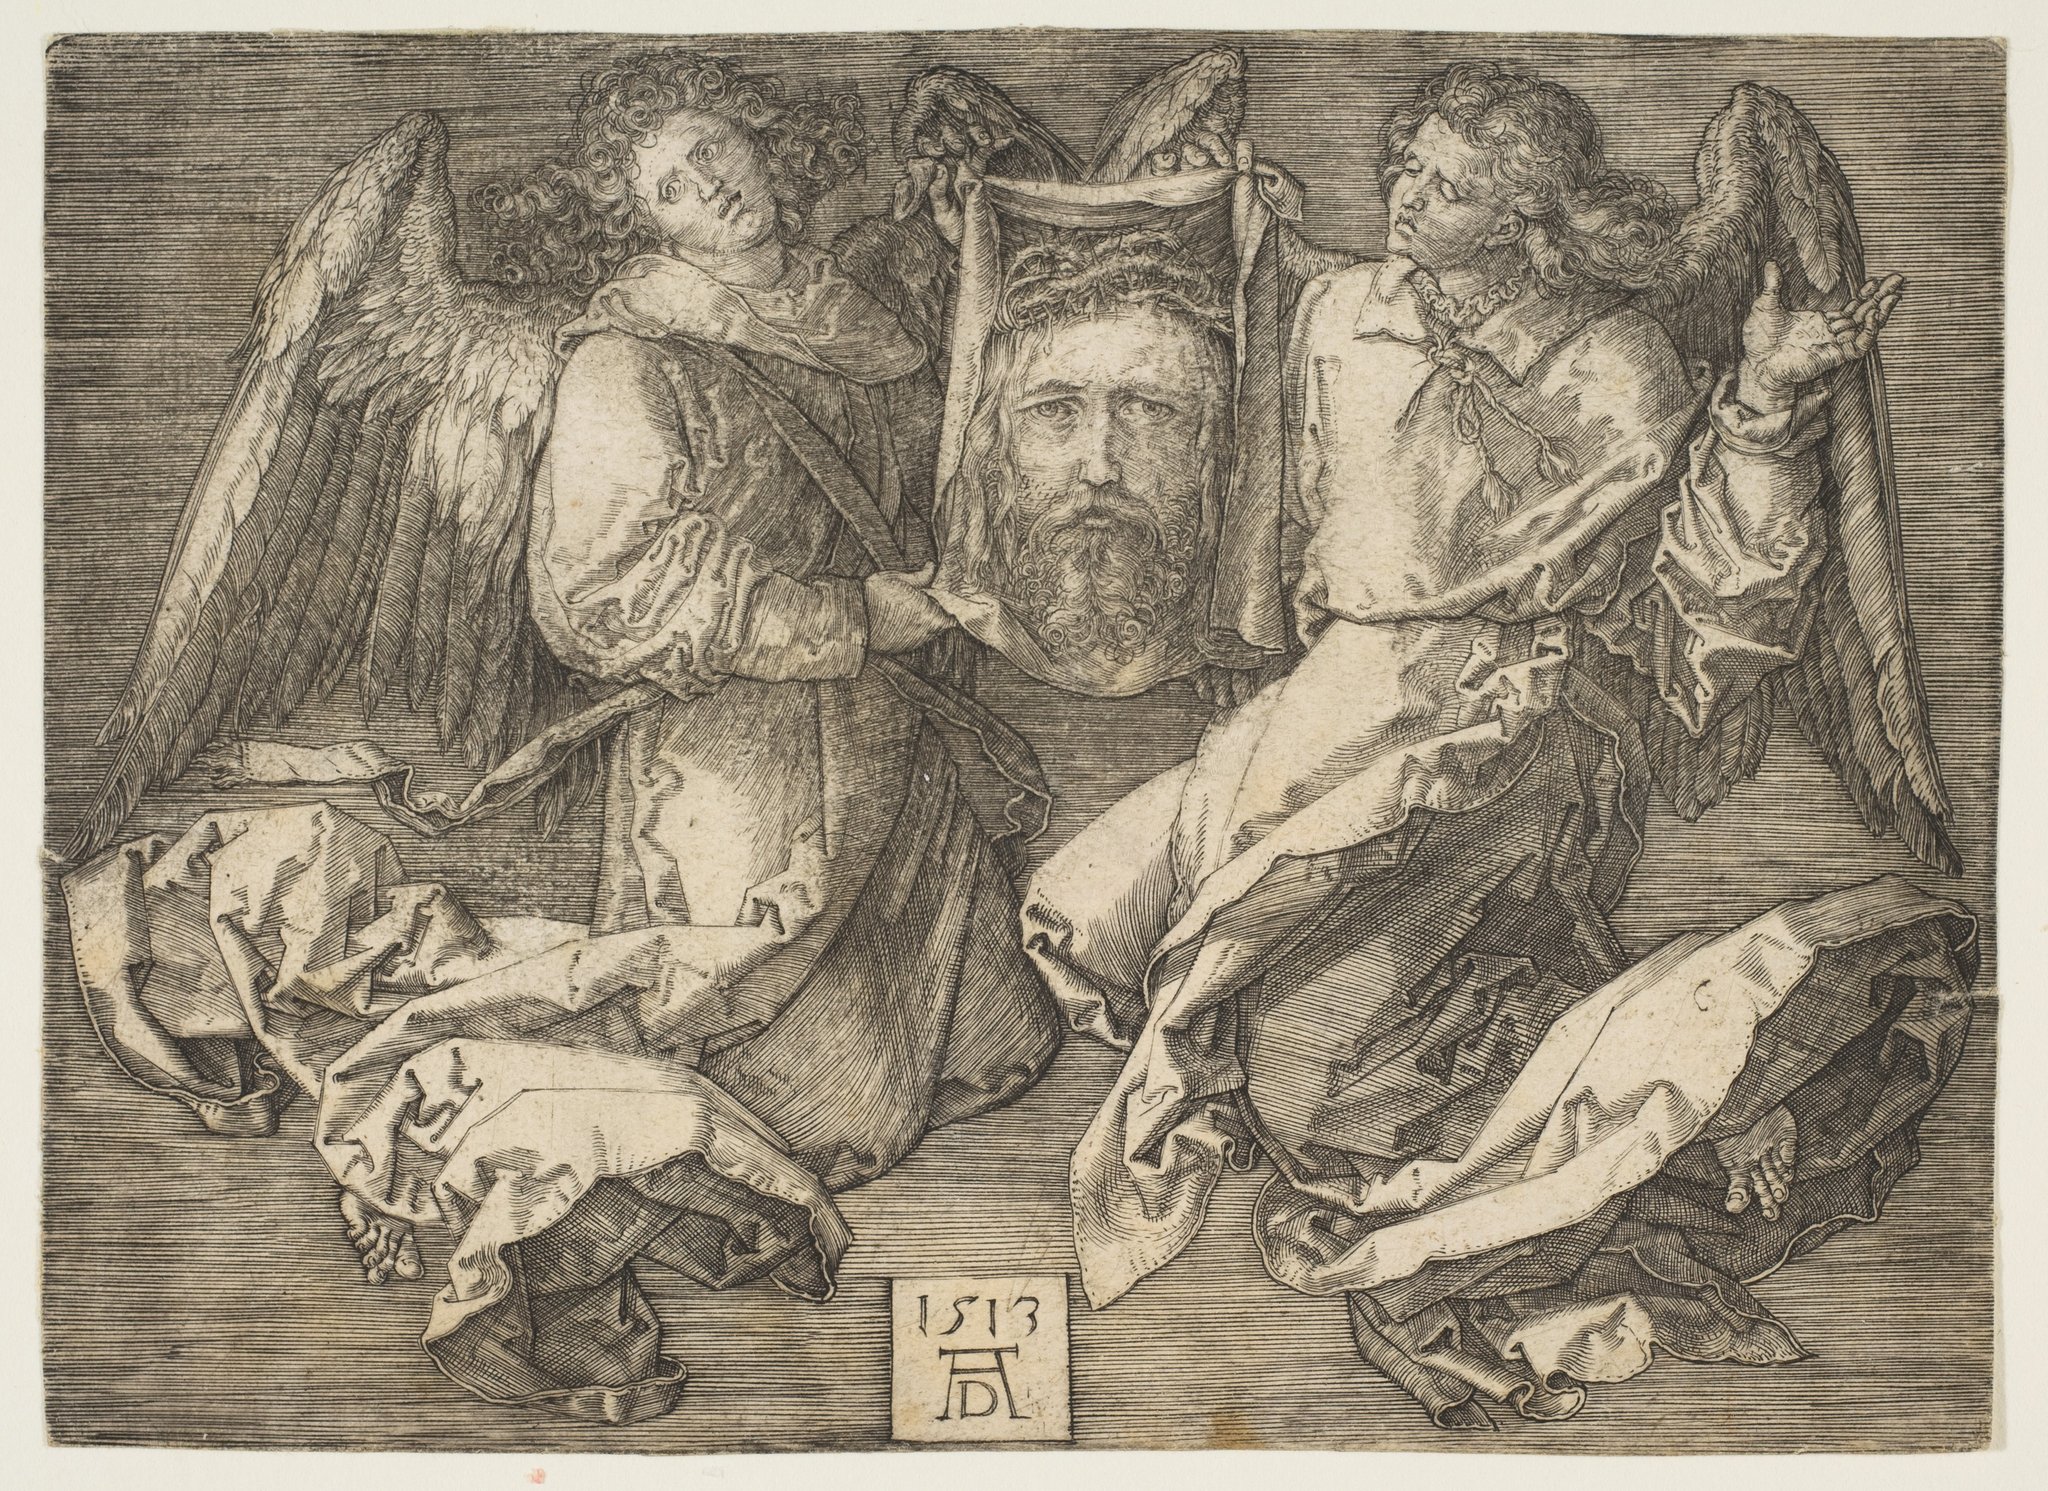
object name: print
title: Sudarium Held by Two Angels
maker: albrecht dürer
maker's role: artist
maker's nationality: german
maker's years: 1471-1528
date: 1513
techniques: engraving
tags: angels,christ